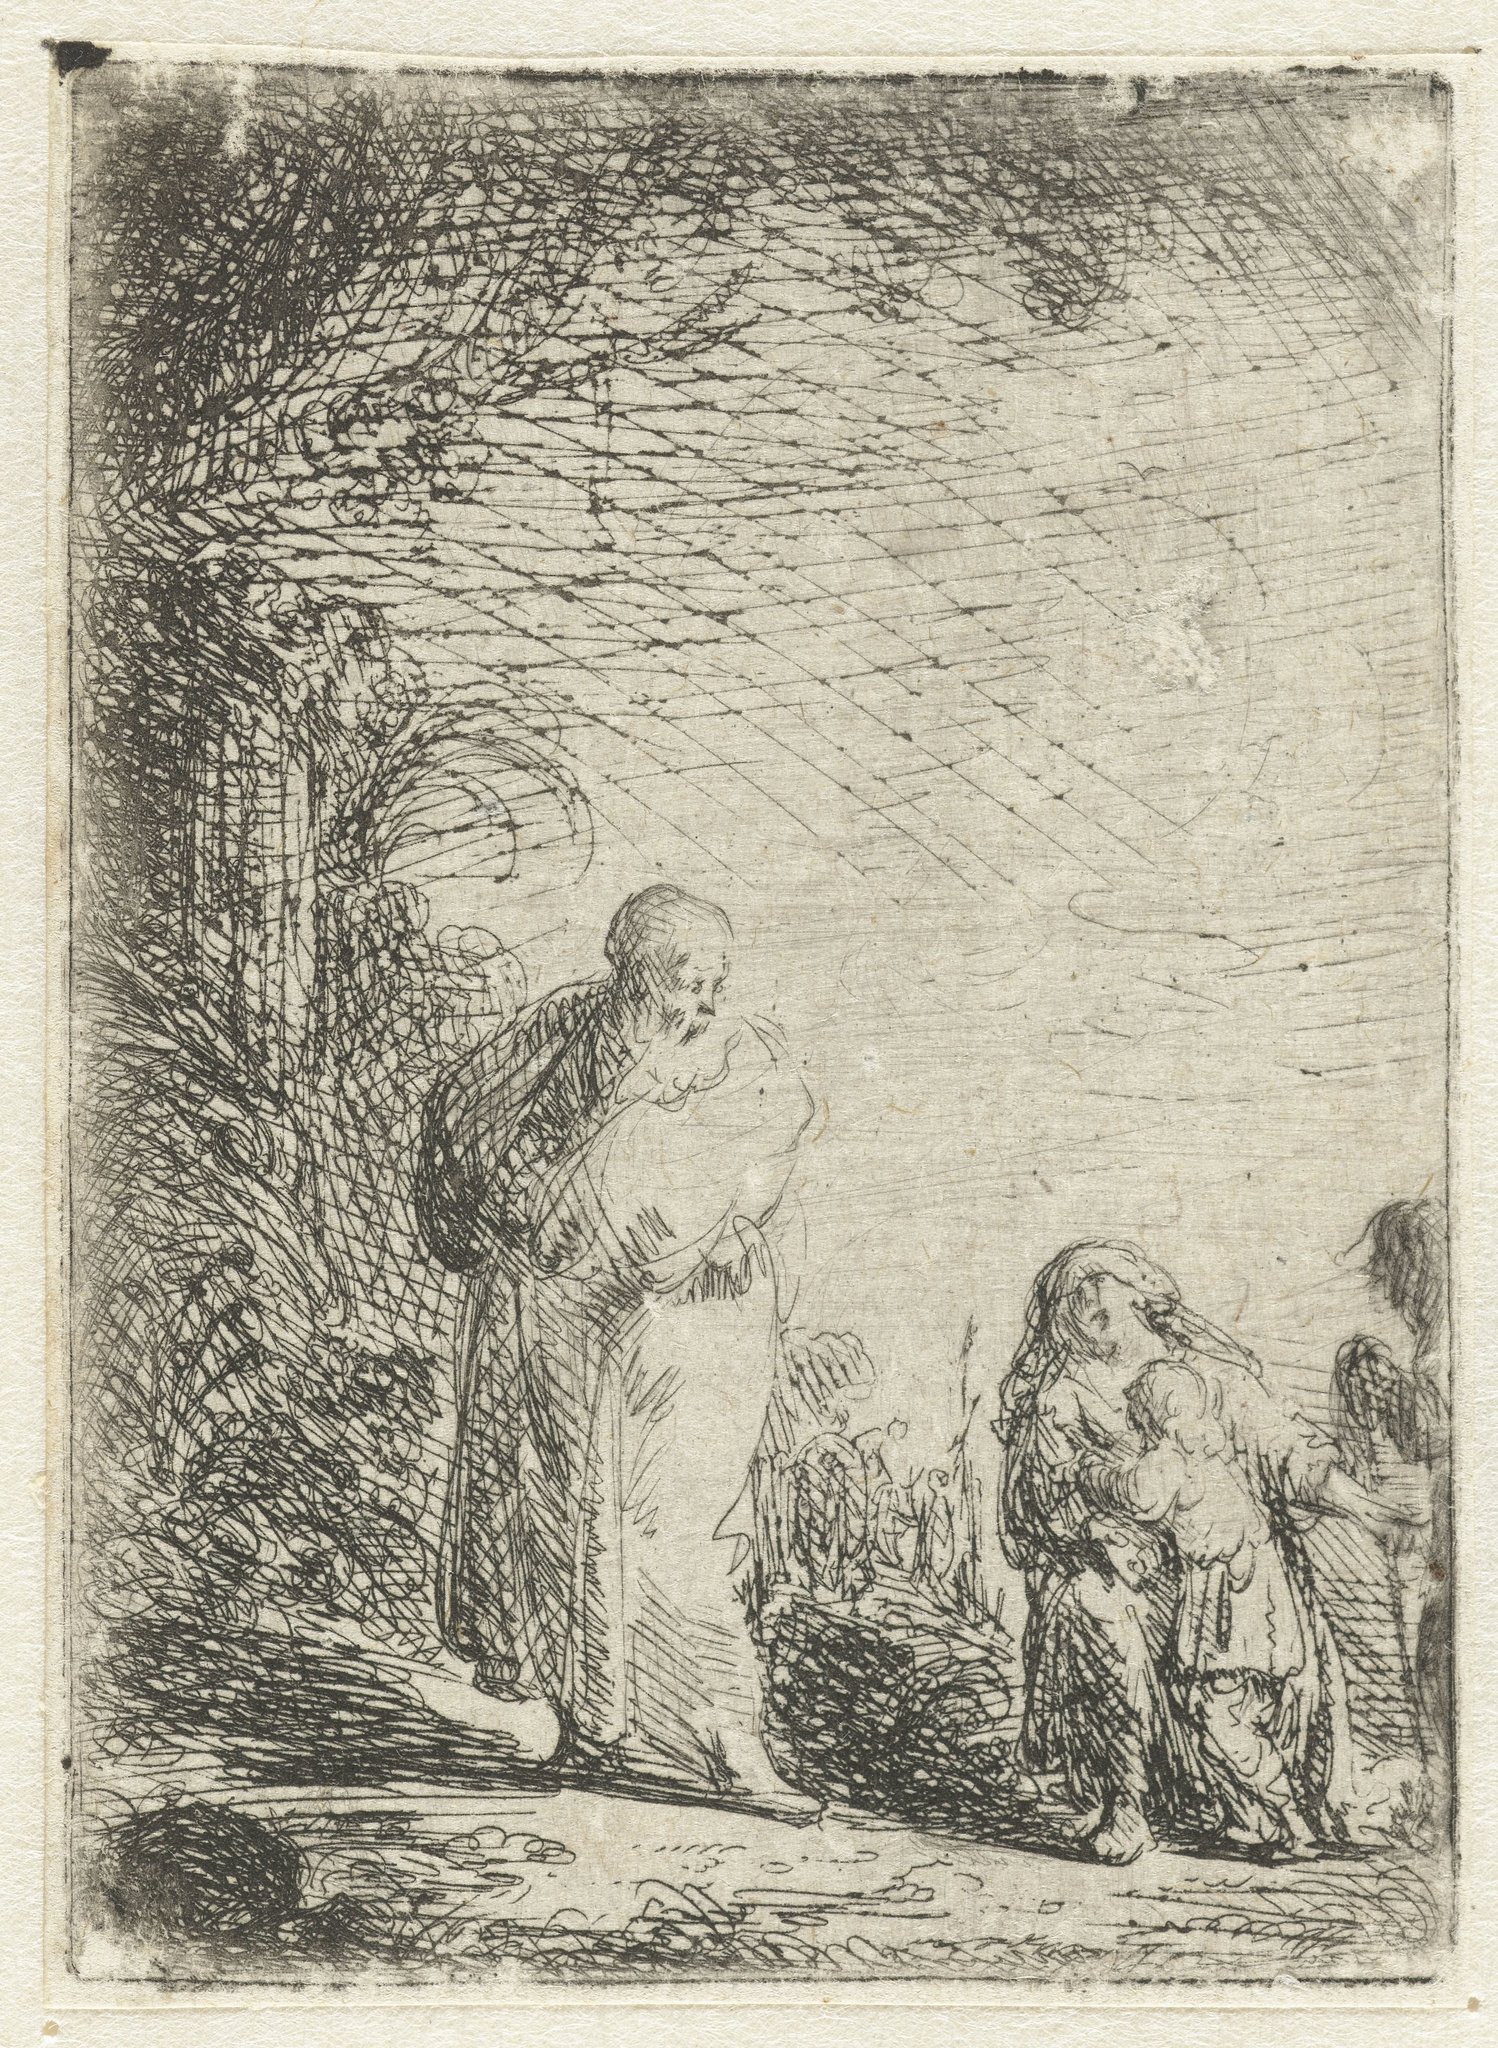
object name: print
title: Abraham verdrijft Hagar en Ismaël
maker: jan lievens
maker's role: draughtsman, painter, print maker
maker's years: 1607-1674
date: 1625-1674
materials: paper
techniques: etching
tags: the banishment of hagar and ishmael (genesis 21:9-21)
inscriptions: collector's mark: Lugt 240